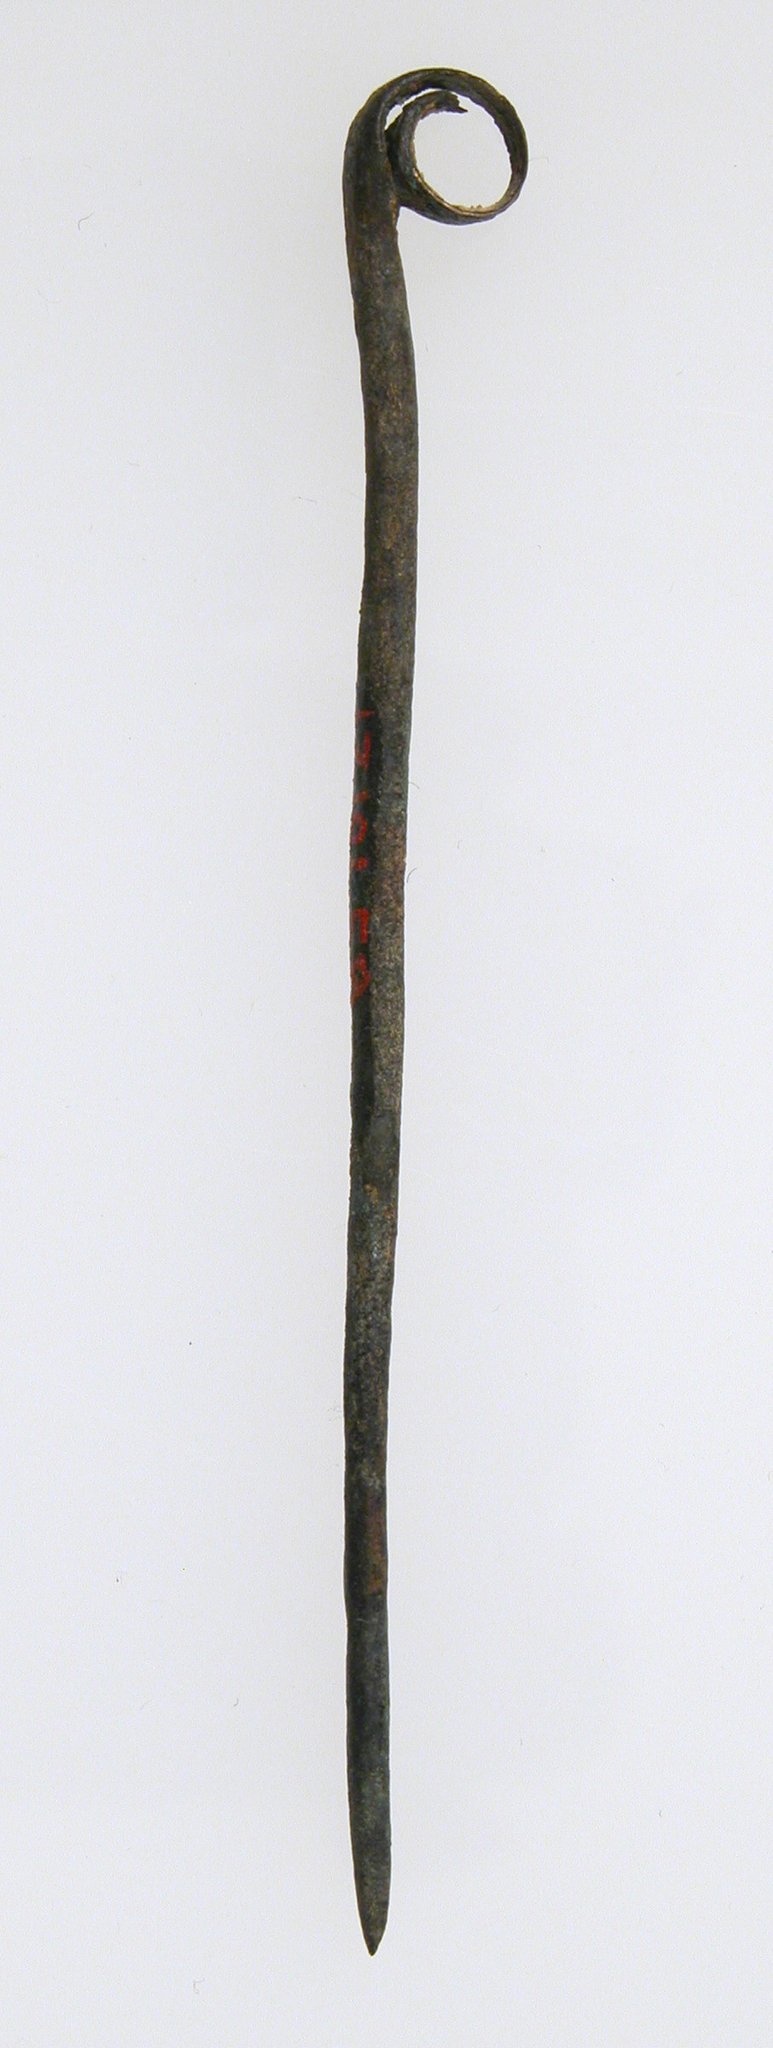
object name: hairpin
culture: roman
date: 200-500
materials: copper alloy